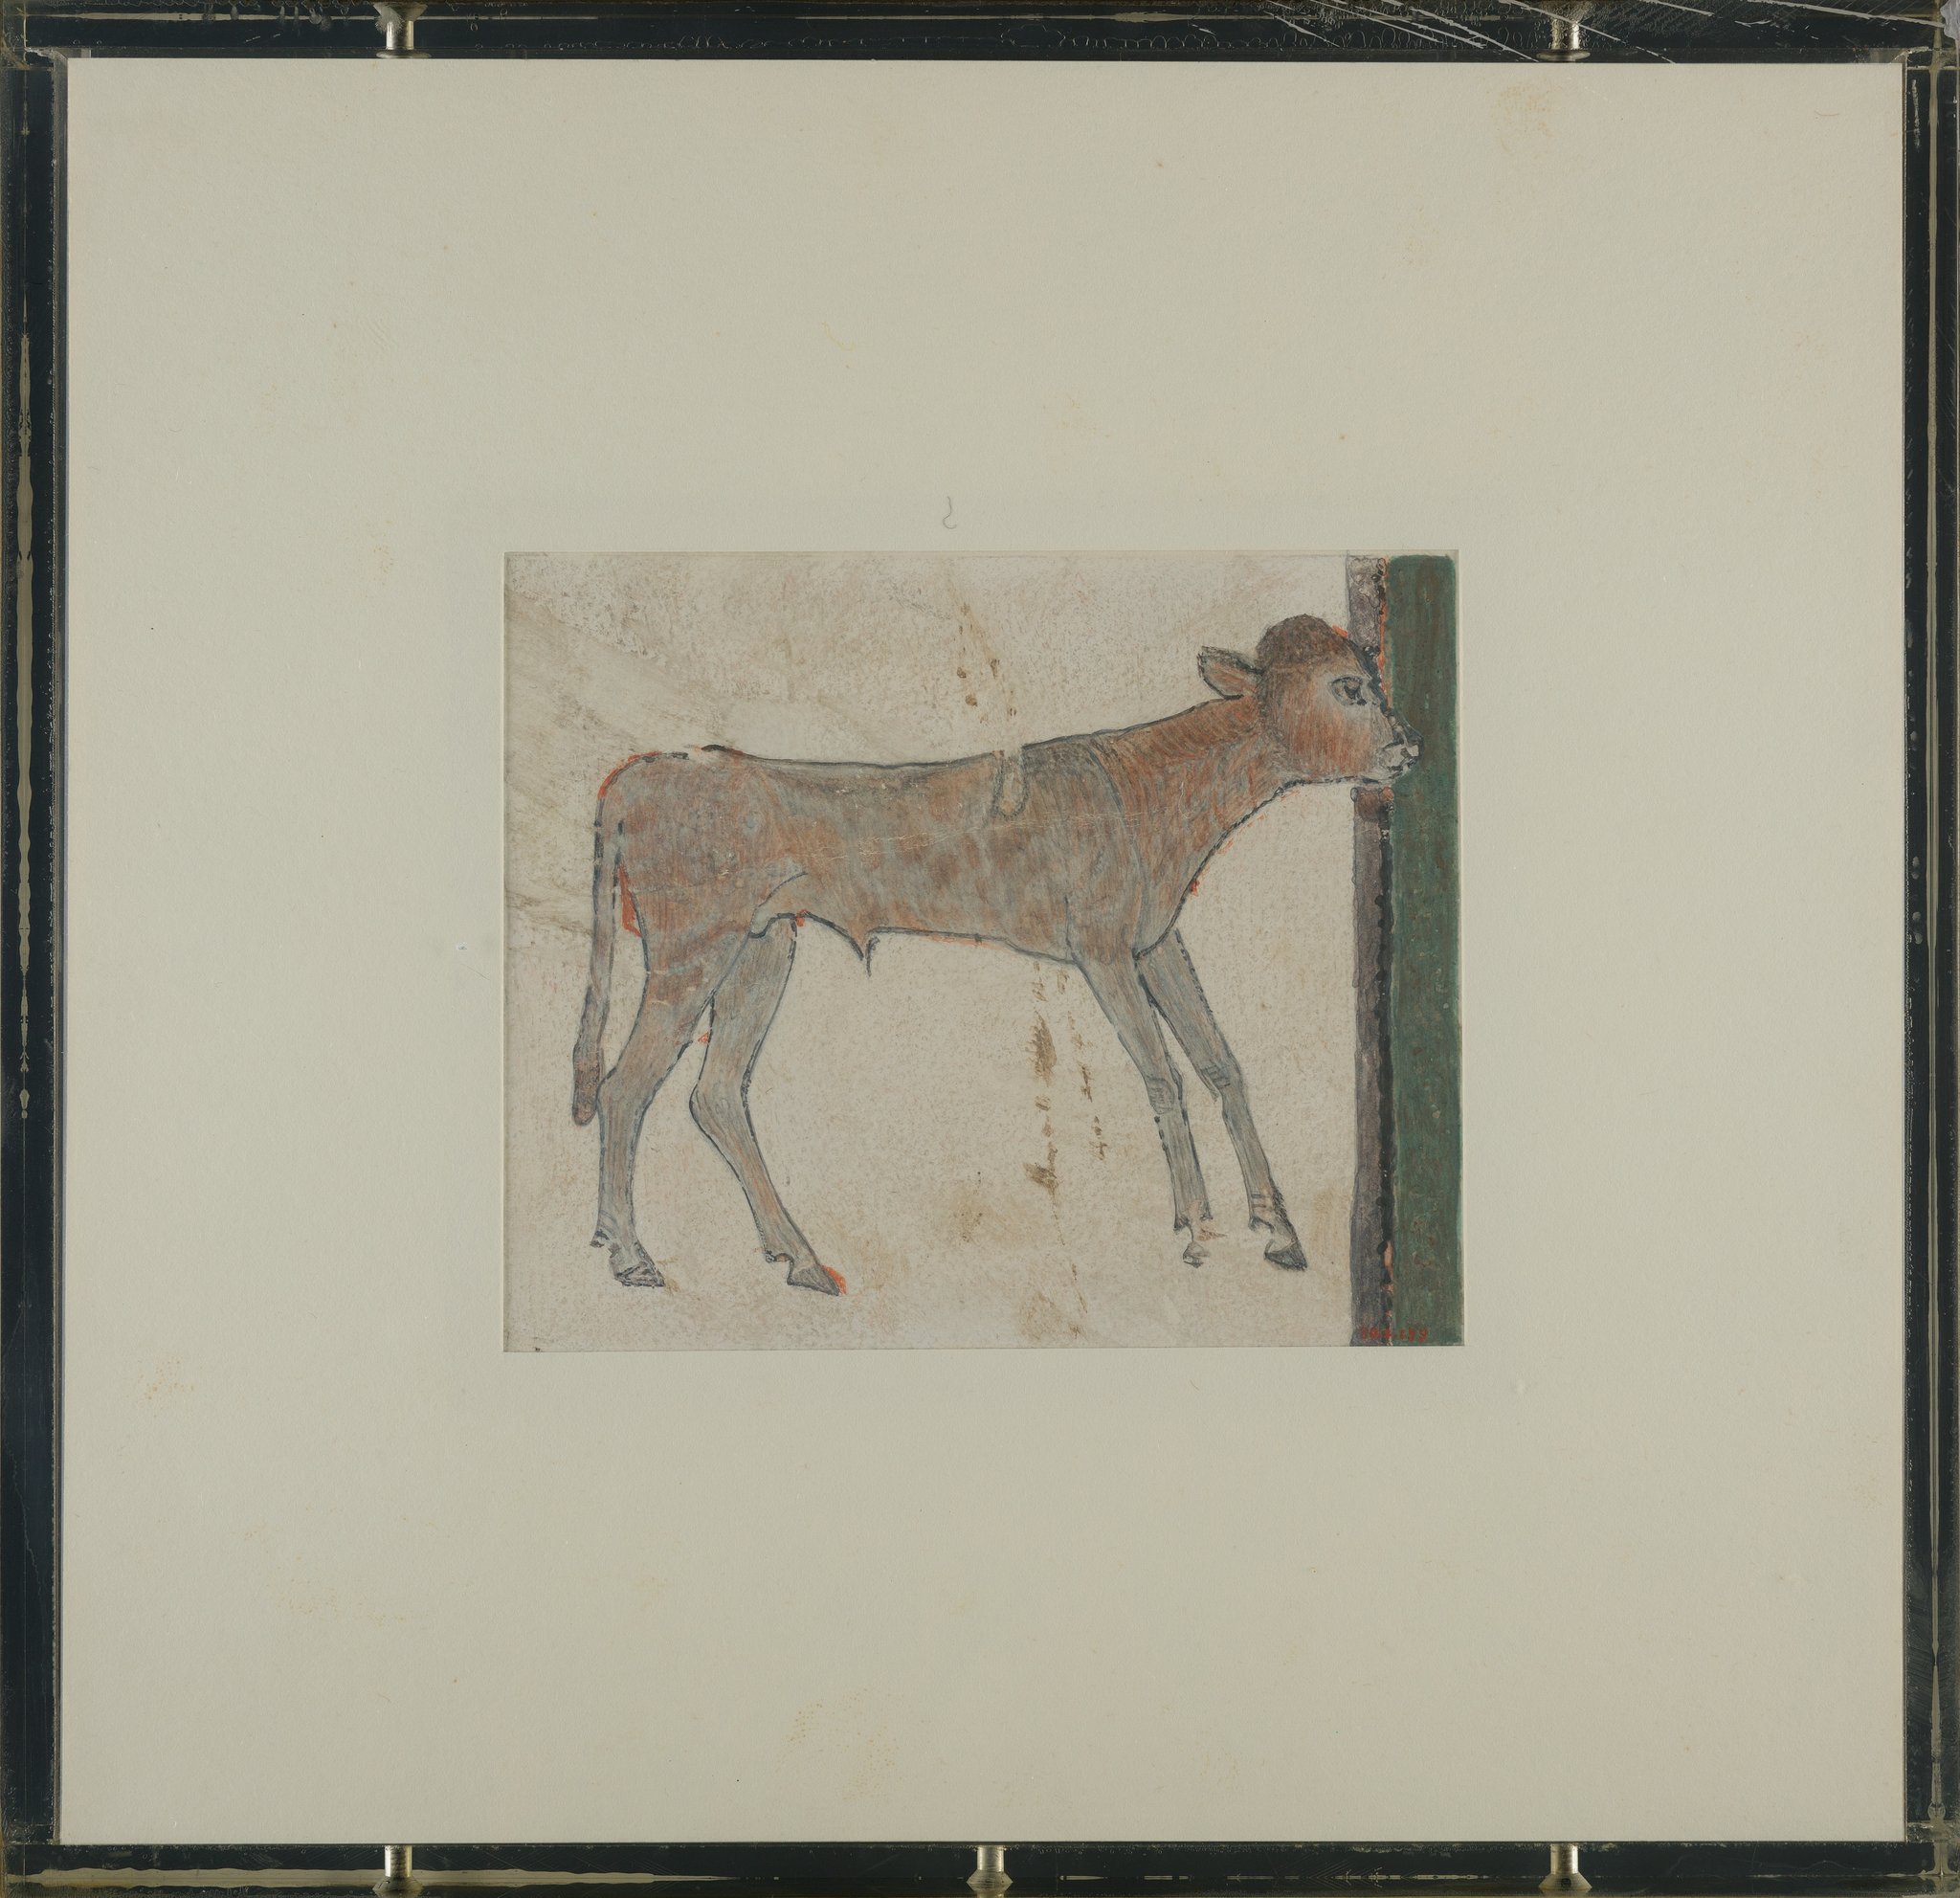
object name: facsimile, nebamun, ipuky tt 181, calf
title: Calf, Tomb of Nebamun and Ipuky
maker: norman de garis davies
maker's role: artist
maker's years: 1865-1941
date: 1390-1349 BCE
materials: paper, paint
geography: egypt